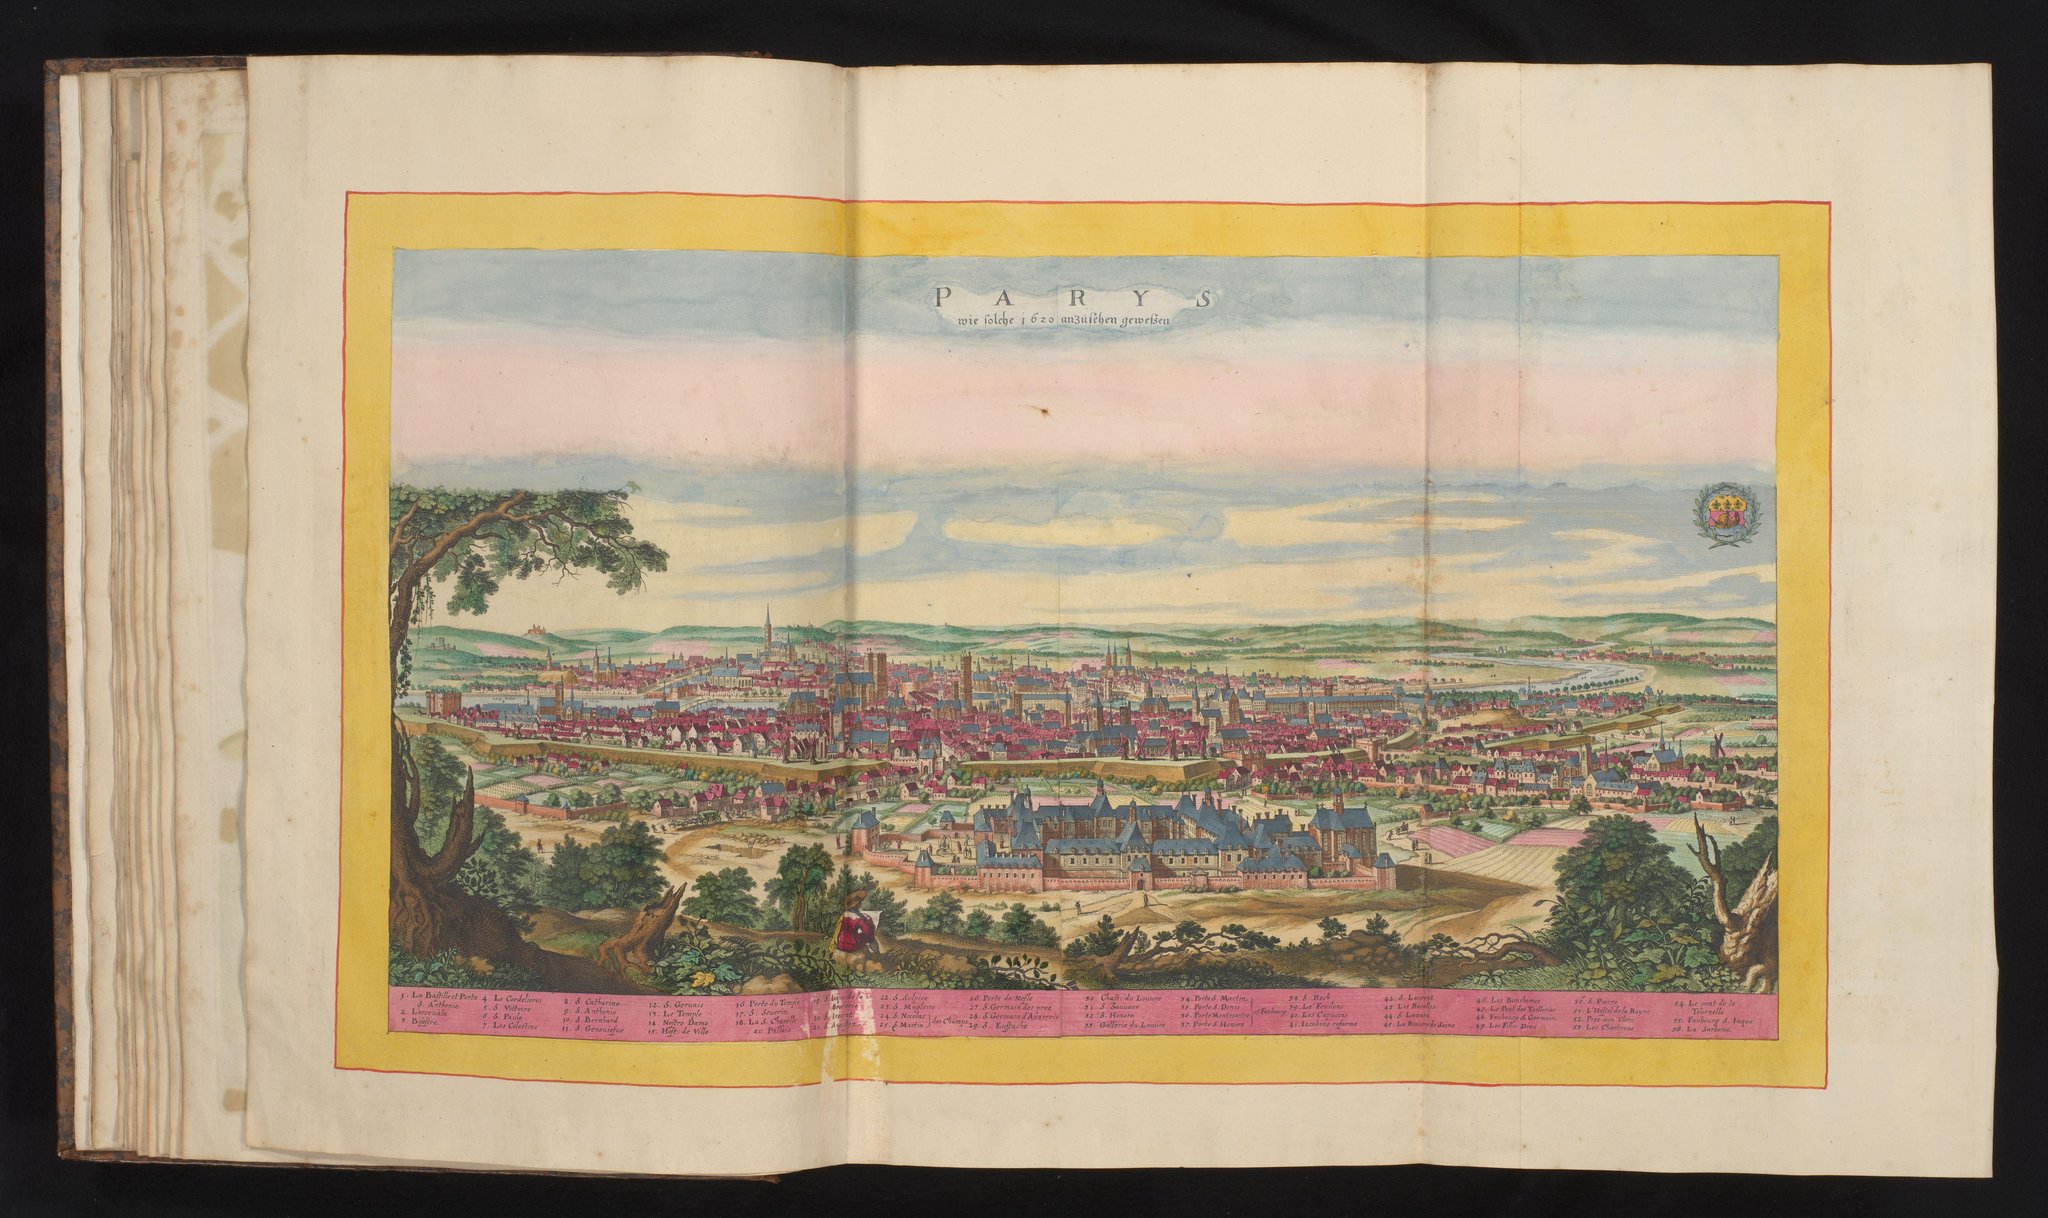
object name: album leaf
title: Parys wie solche 1620 auzusehen gewesen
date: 1655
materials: paper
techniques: engraving, etching, hand coloring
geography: paris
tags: prospect of city, town panorama, silhouette of city, paris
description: Prent origineel vervaardigd als boekillustratie voor: Zeiller, Martin. Topographia Galliae, oder Beschreibung und Contrafaitung der vornehmbsten und bekantisten Oerter in dem mächtigen und grossen Königreich Frankreich, 13 delen. Frankfurt am Main: Caspar Merian, 1655-1661. De prent werd voor het eerst gepubliceerd in deel 1: Topographia Galliae, 1655.